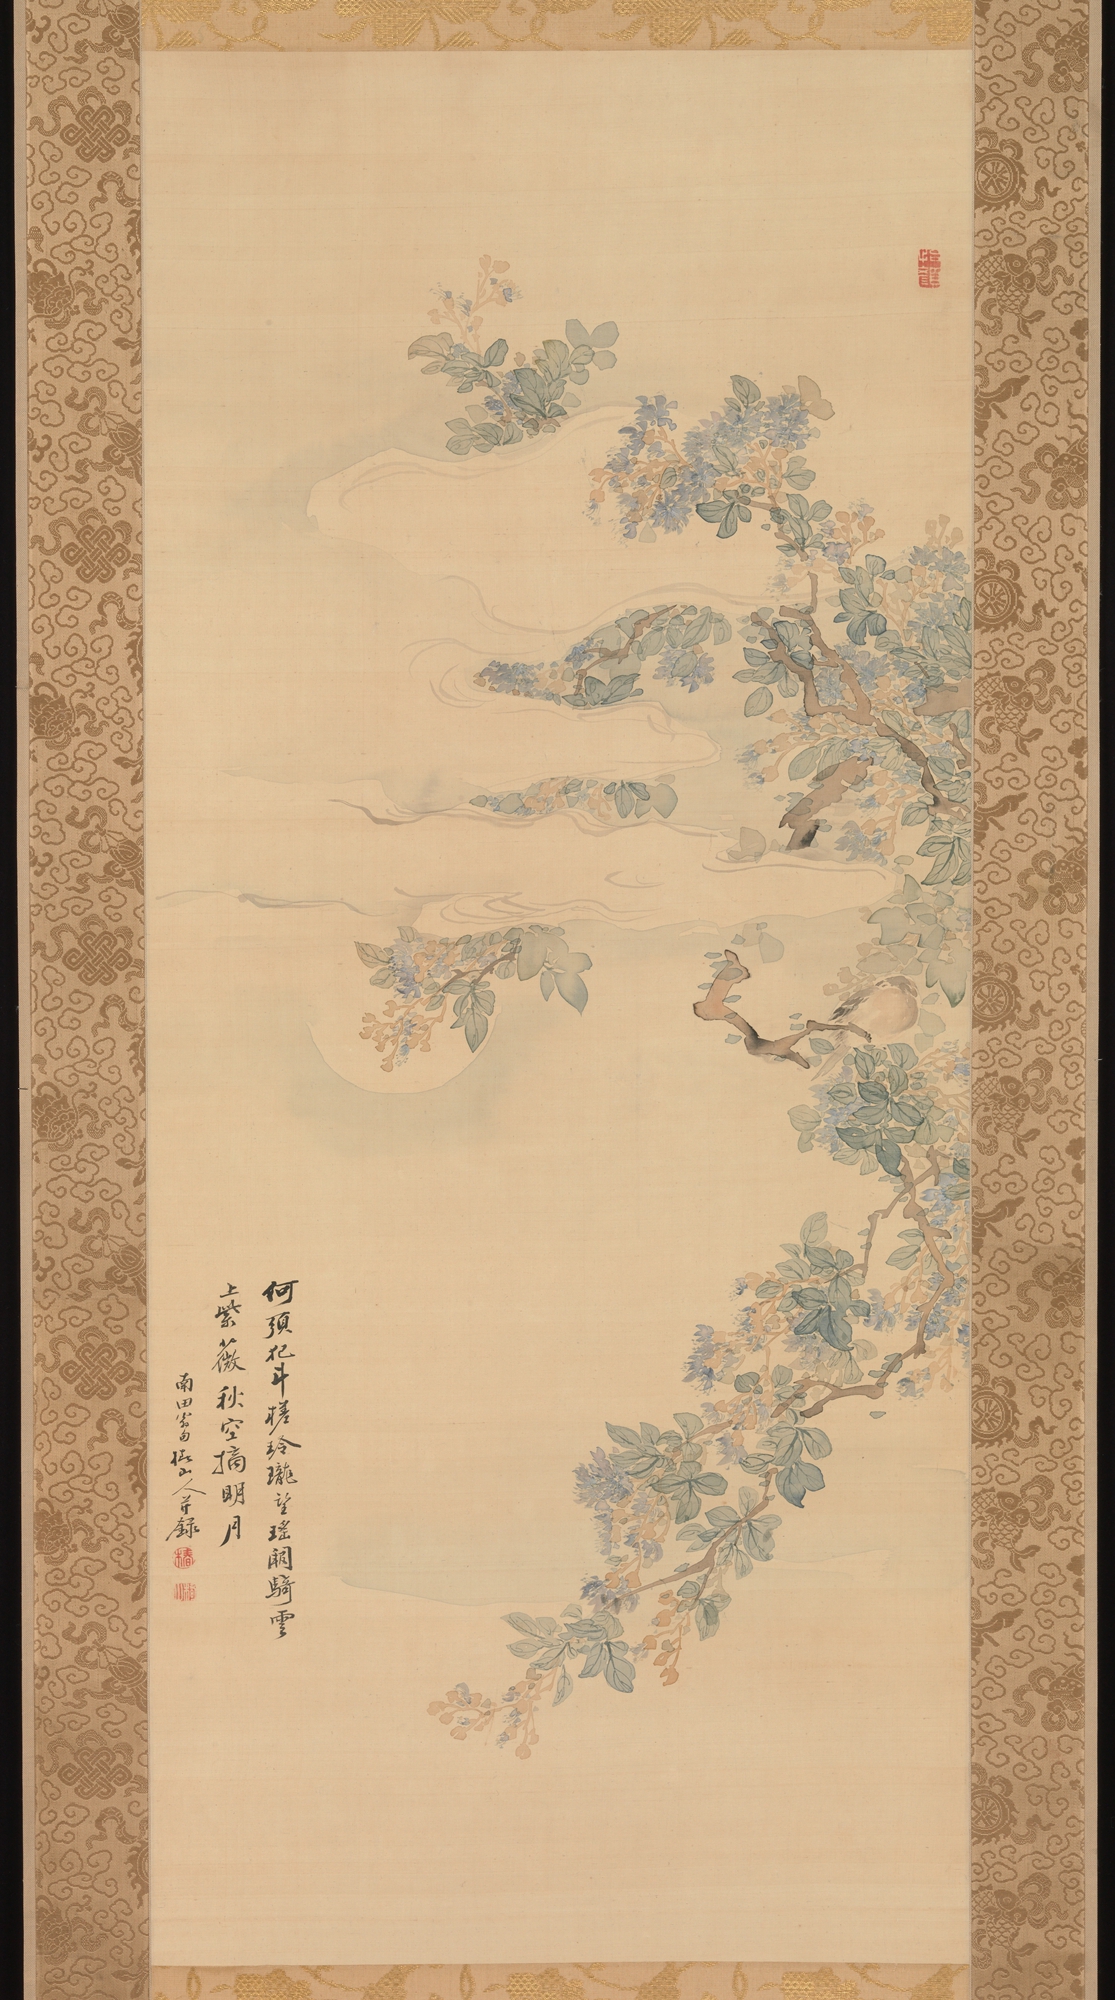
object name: hanging scroll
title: Small Bird on a Crepe Myrtle Branch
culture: japanese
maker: tsubaki chinzan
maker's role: artist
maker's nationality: japanese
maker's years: 1801-1854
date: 1850-1859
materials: ink, silk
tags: birds,trees